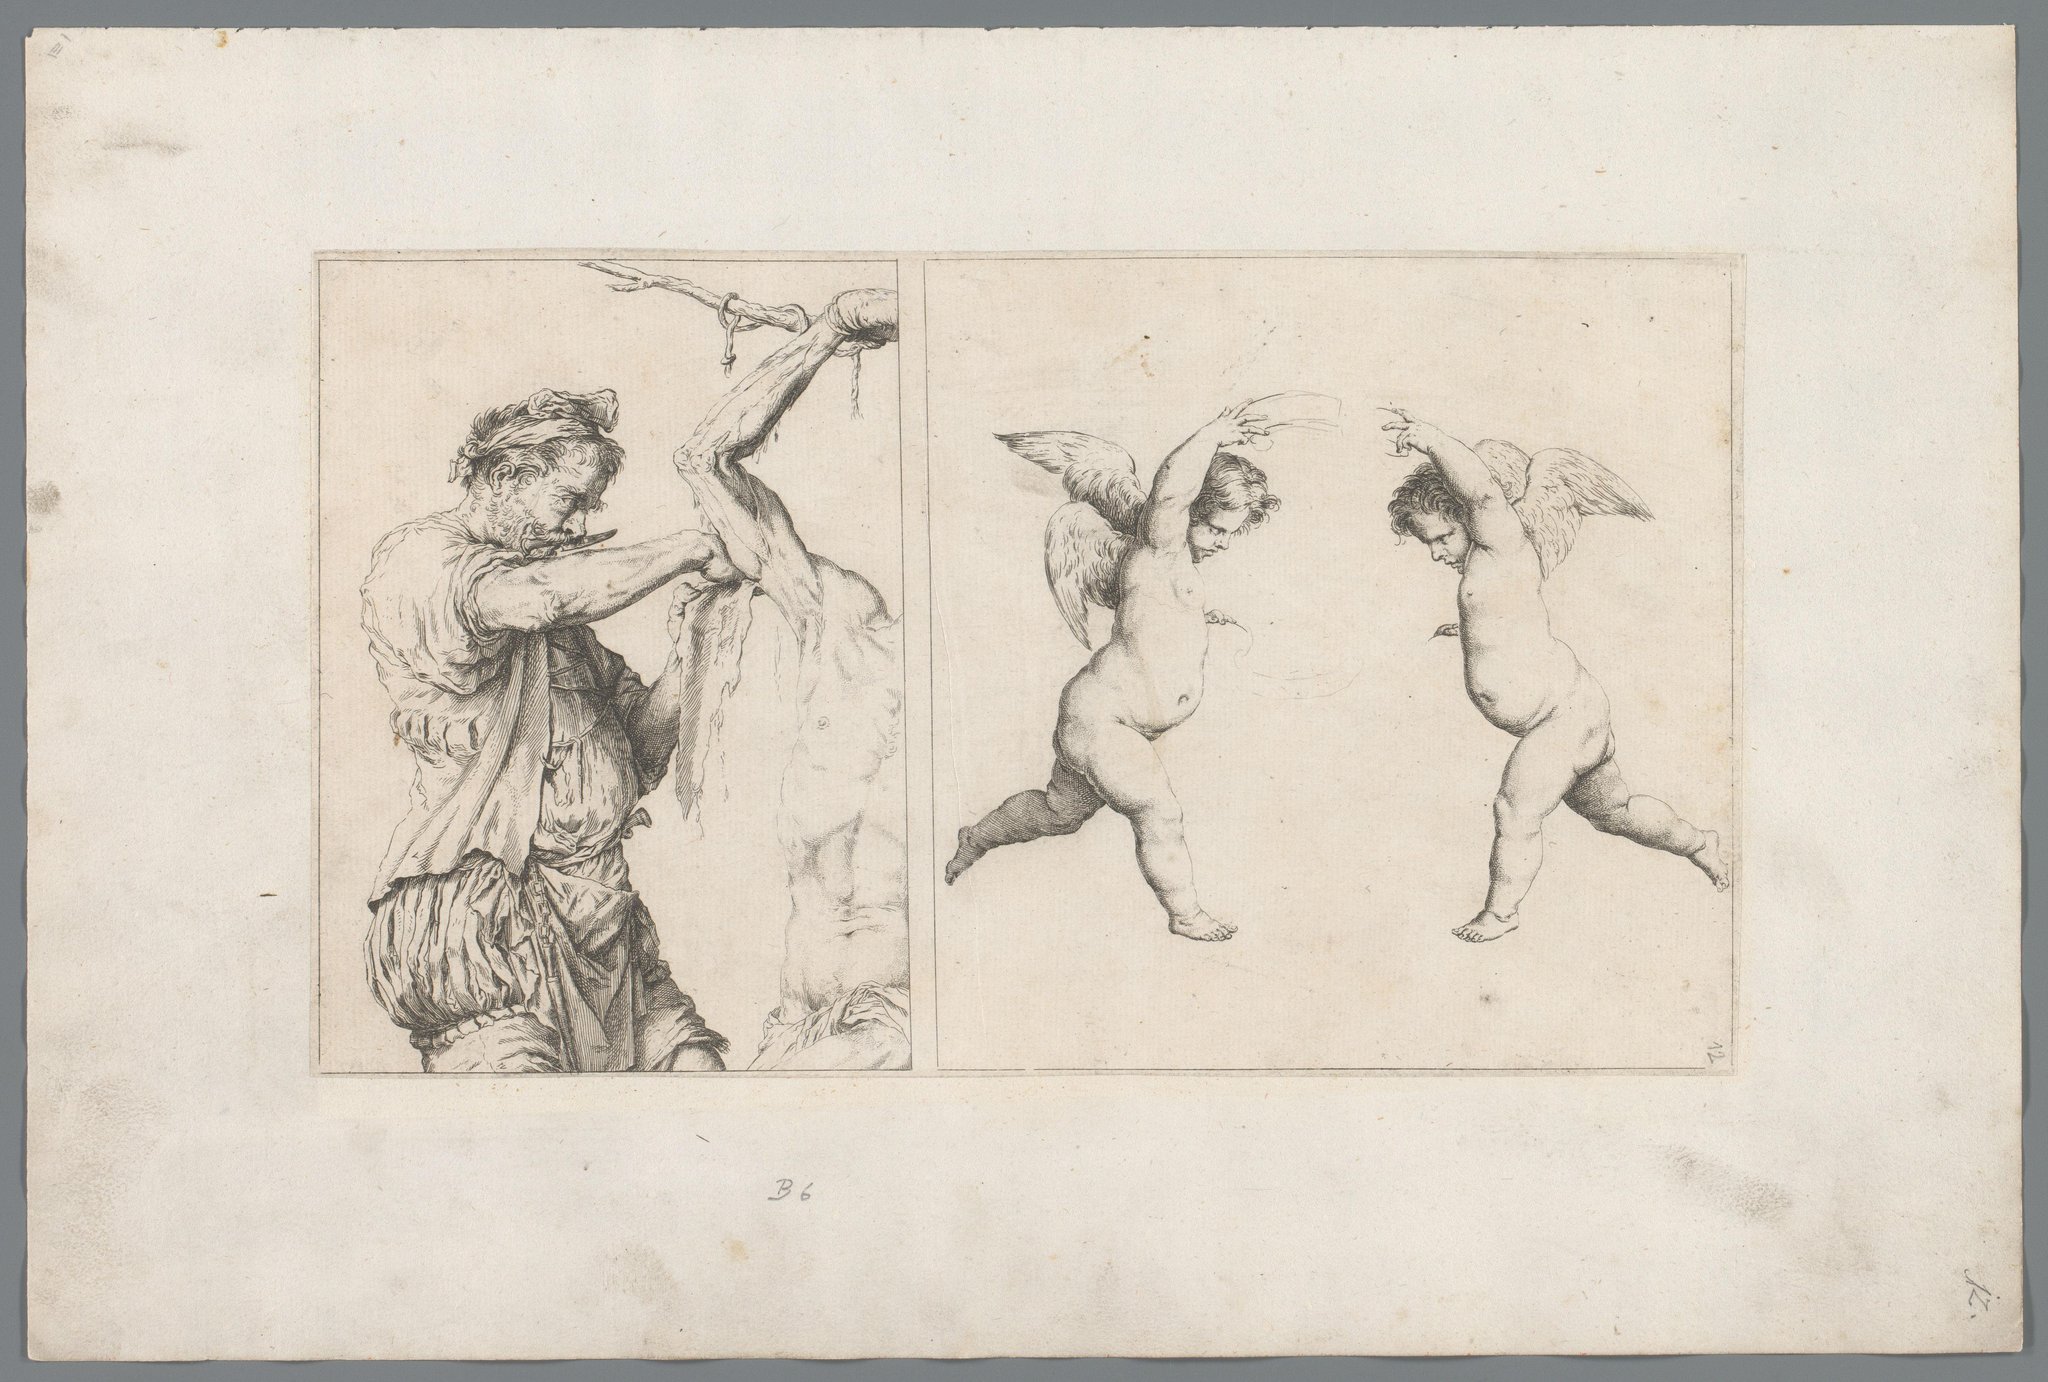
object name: print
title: Detail uit het martelaarschap van H. Bartolomeüs en een studie van twee cherubijnen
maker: Anonymous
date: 1602-1652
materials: paper, pencil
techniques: etching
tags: bartholomew flayed alive, cupids: 'amores', 'amoretti', 'putti'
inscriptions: collector's mark: Lugt 2228, collector's mark: Lugt 2760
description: Prent uit een serie van twaalf prenten en een titelprent.